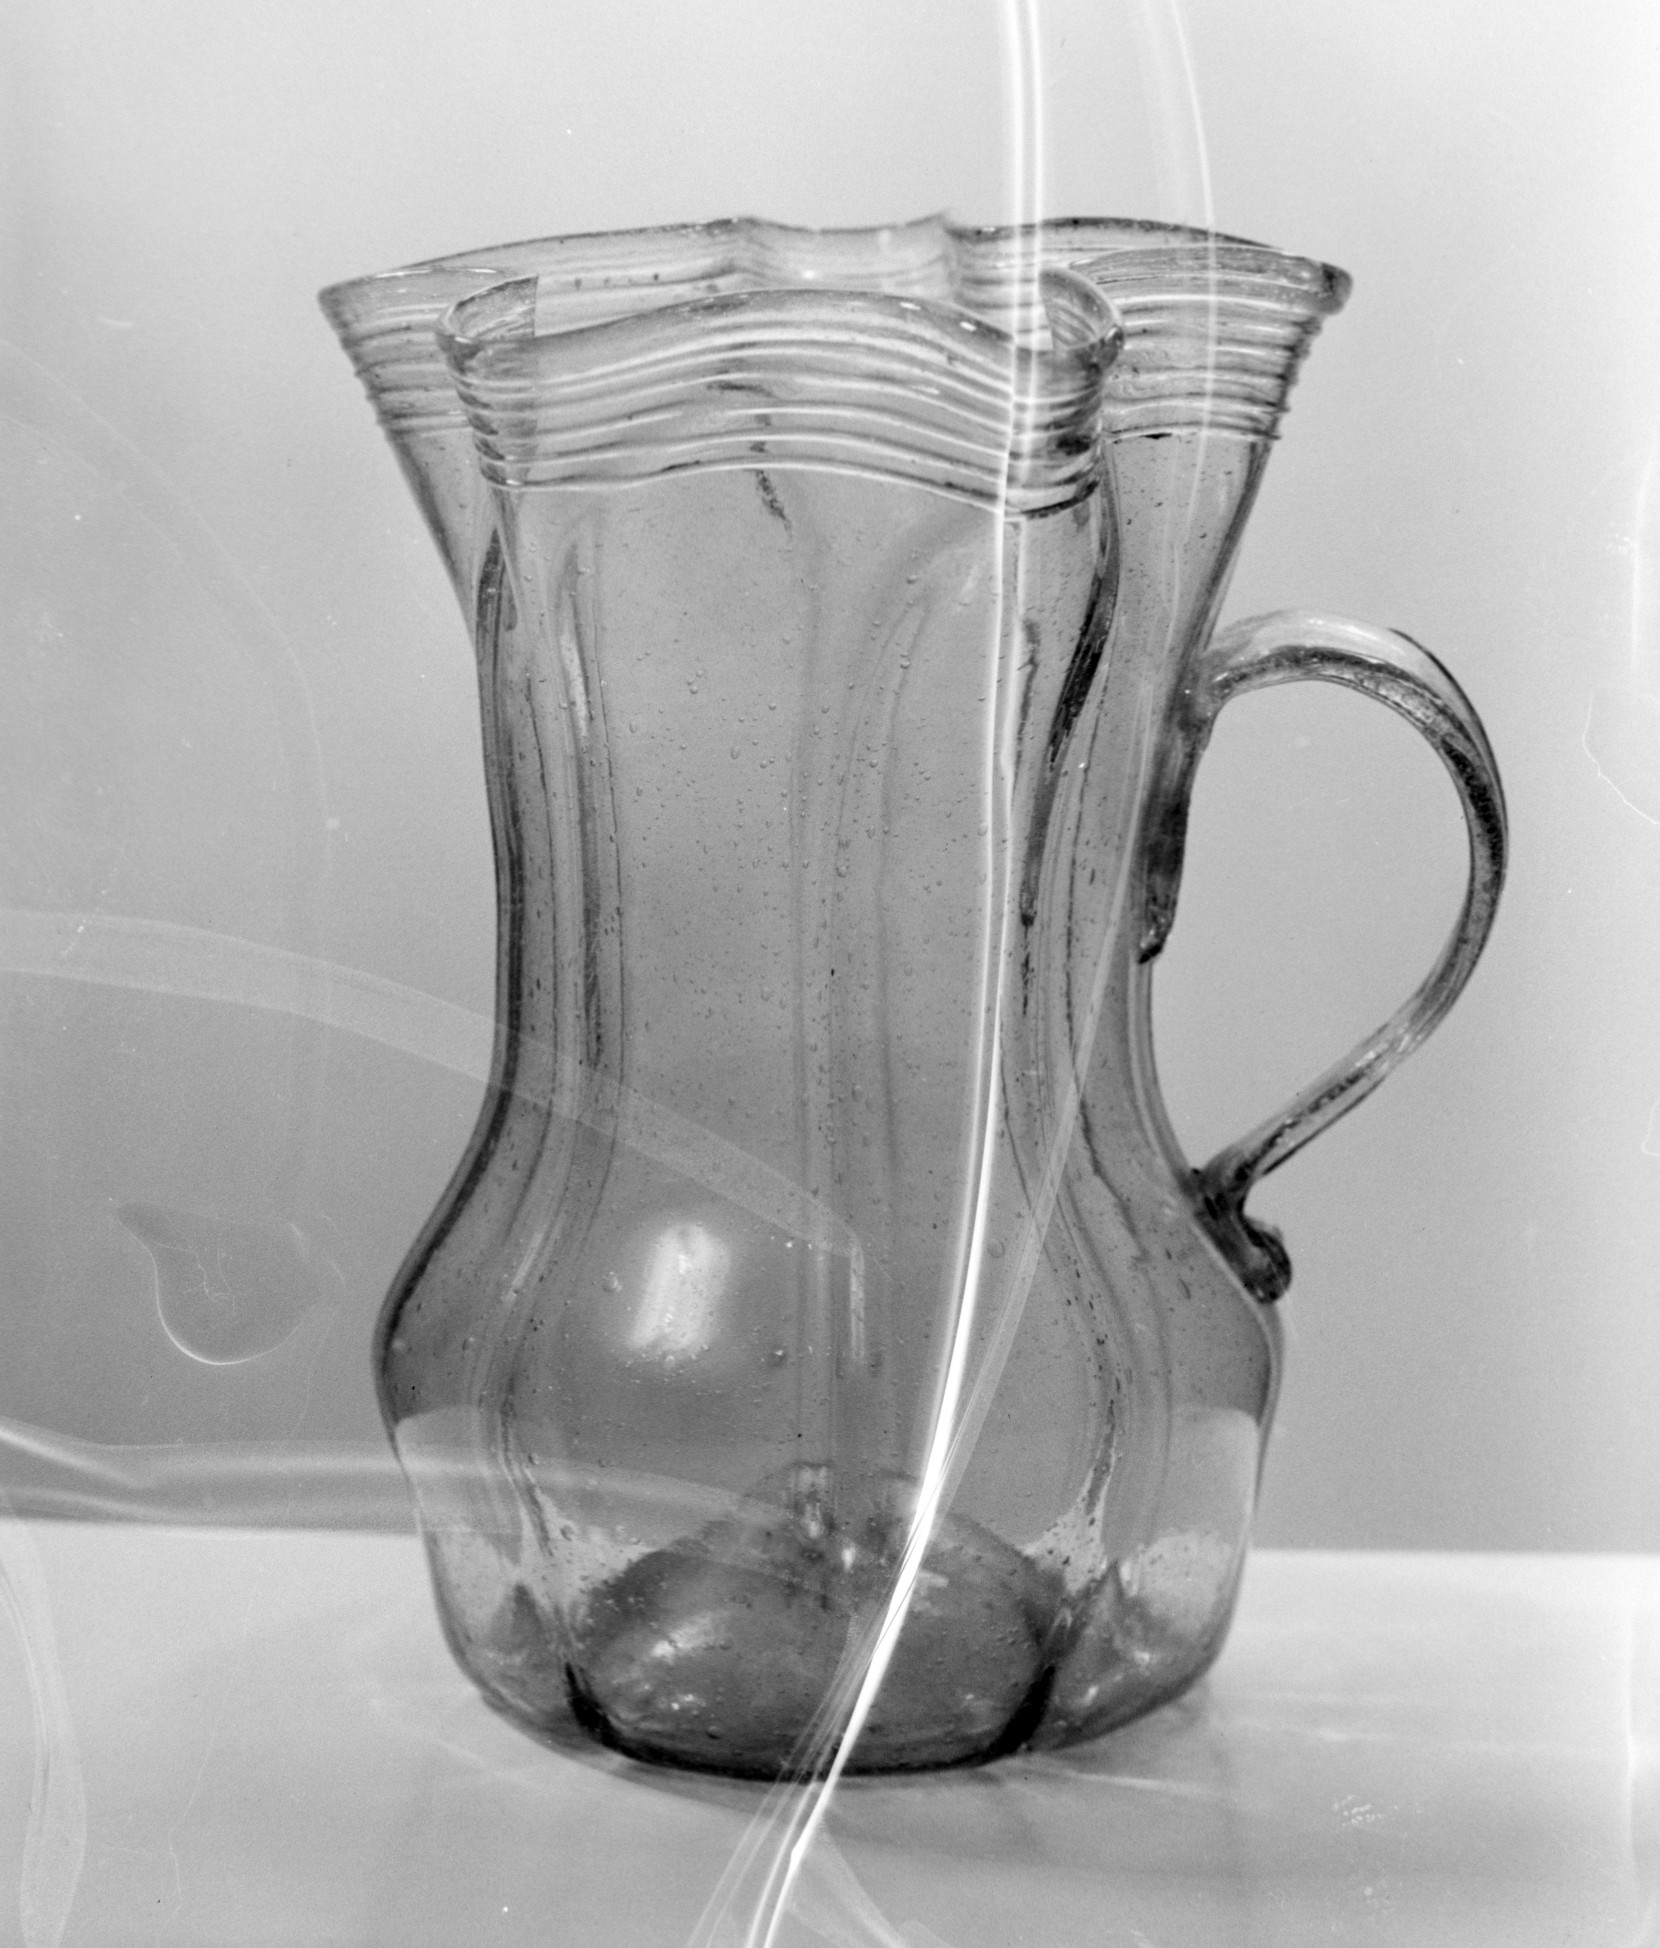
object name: jug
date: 1701-1800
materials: glass